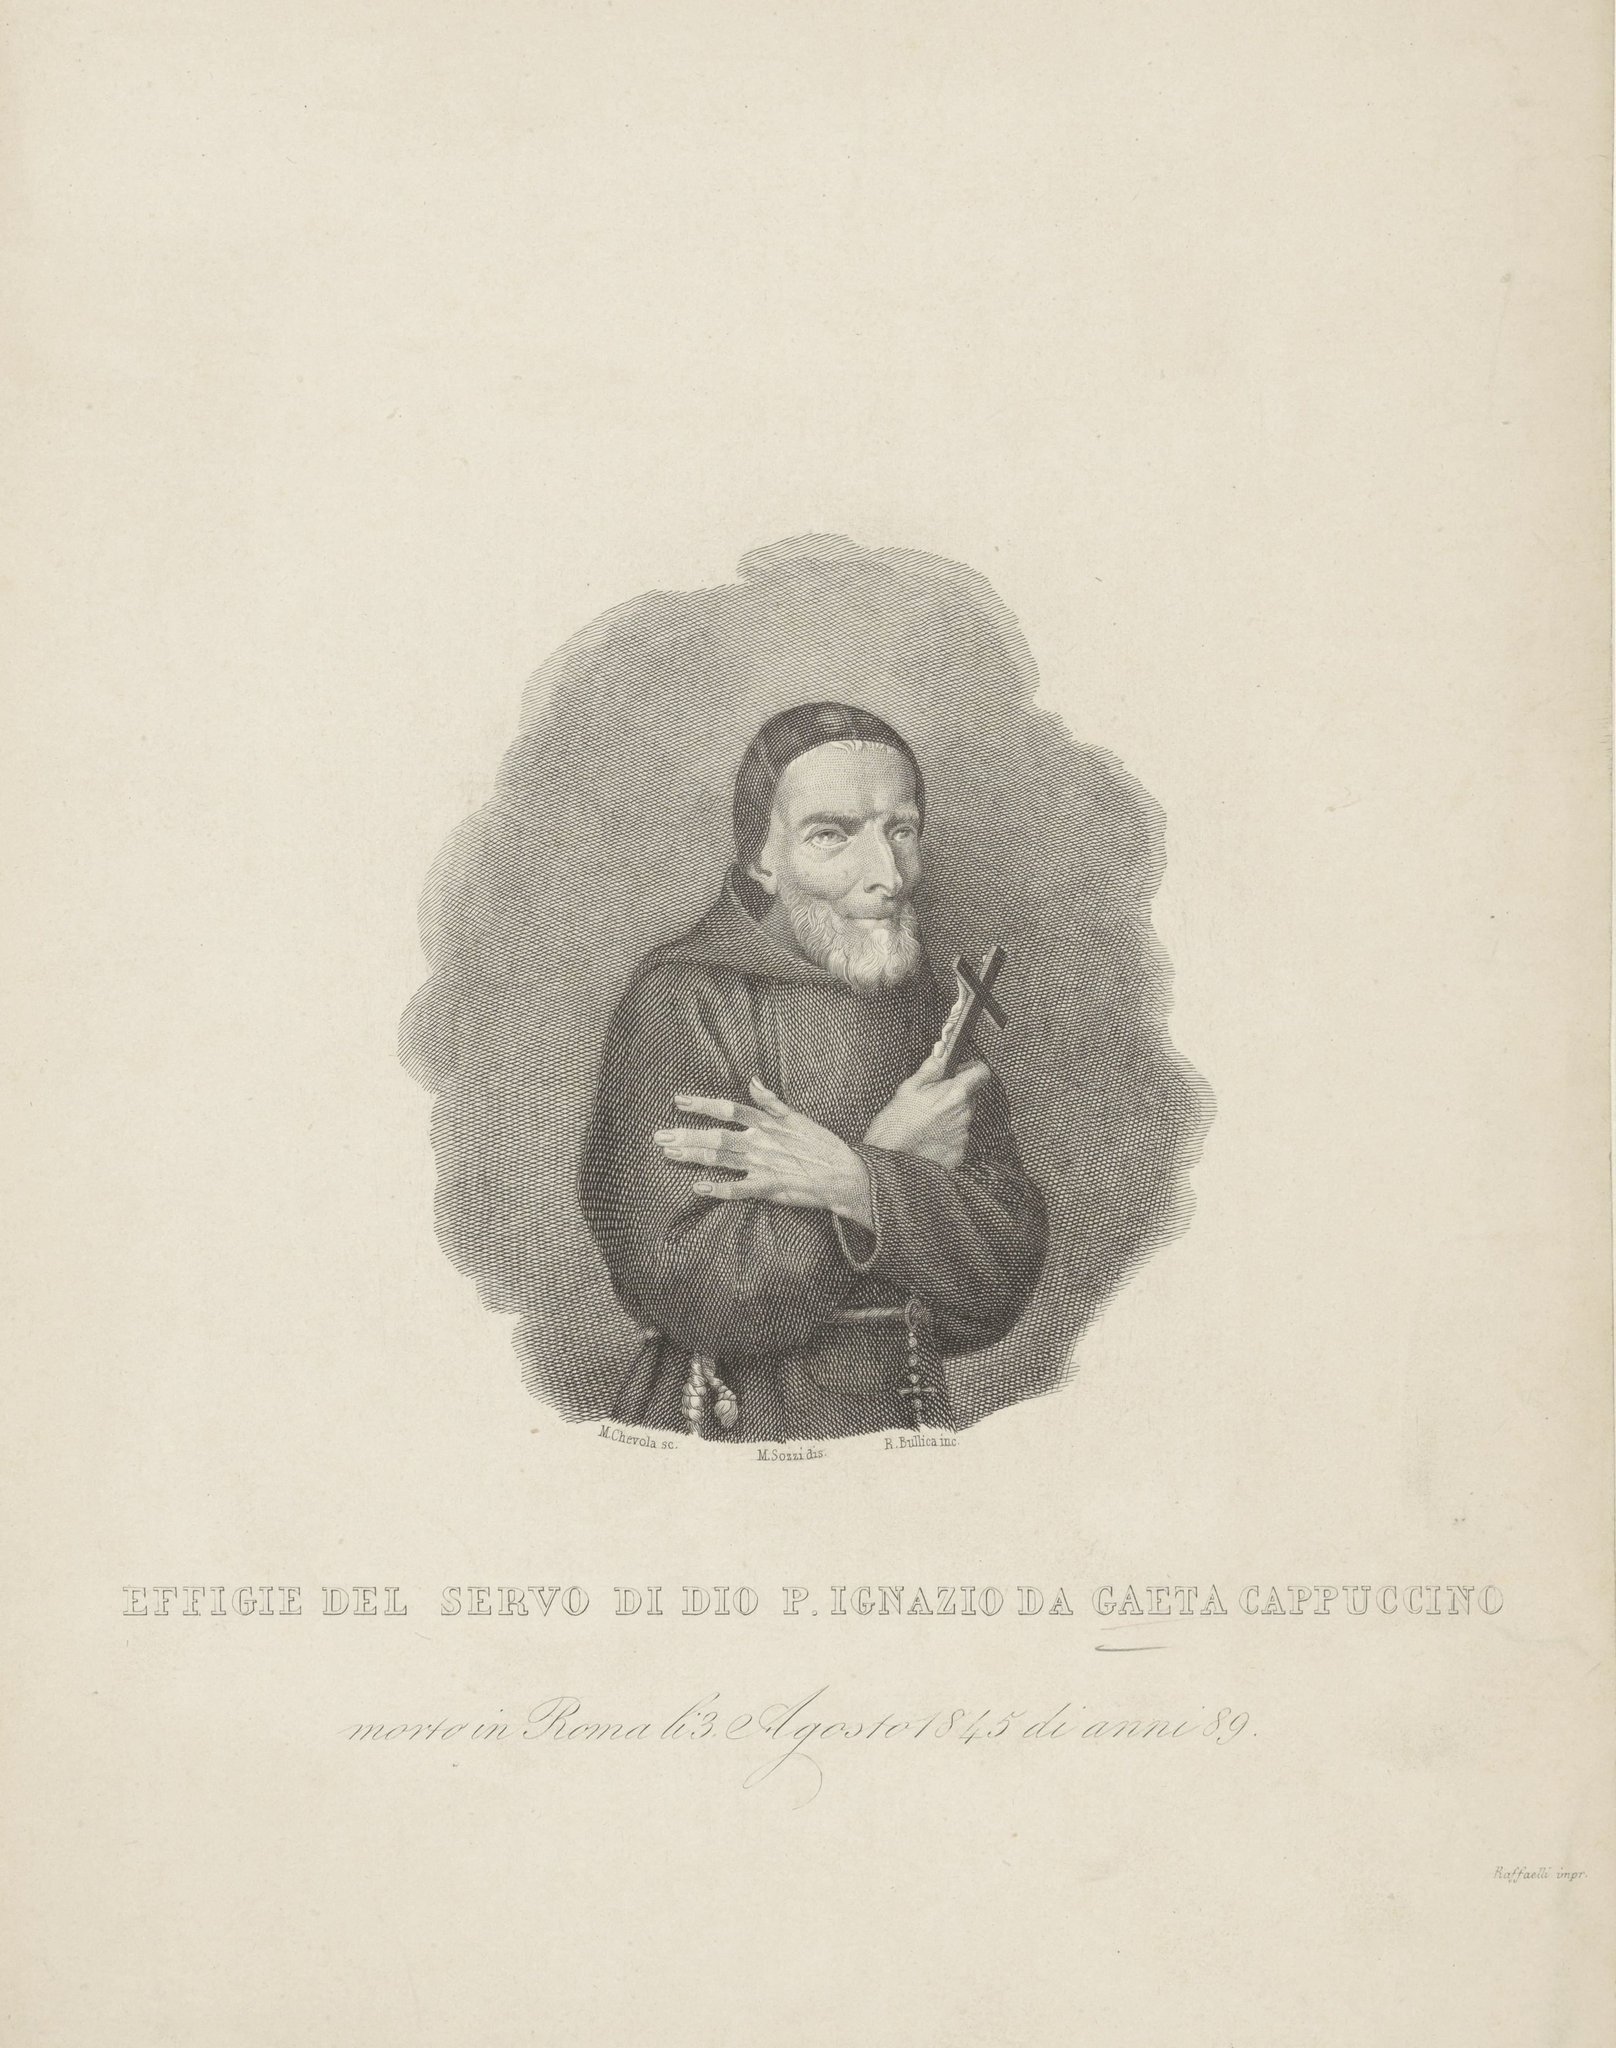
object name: print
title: Portret van Ignazio da Gaeta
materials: paper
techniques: engraving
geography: italy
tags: historical persons, monk(s), friar(s)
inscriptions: collector's mark: Lugt 2228